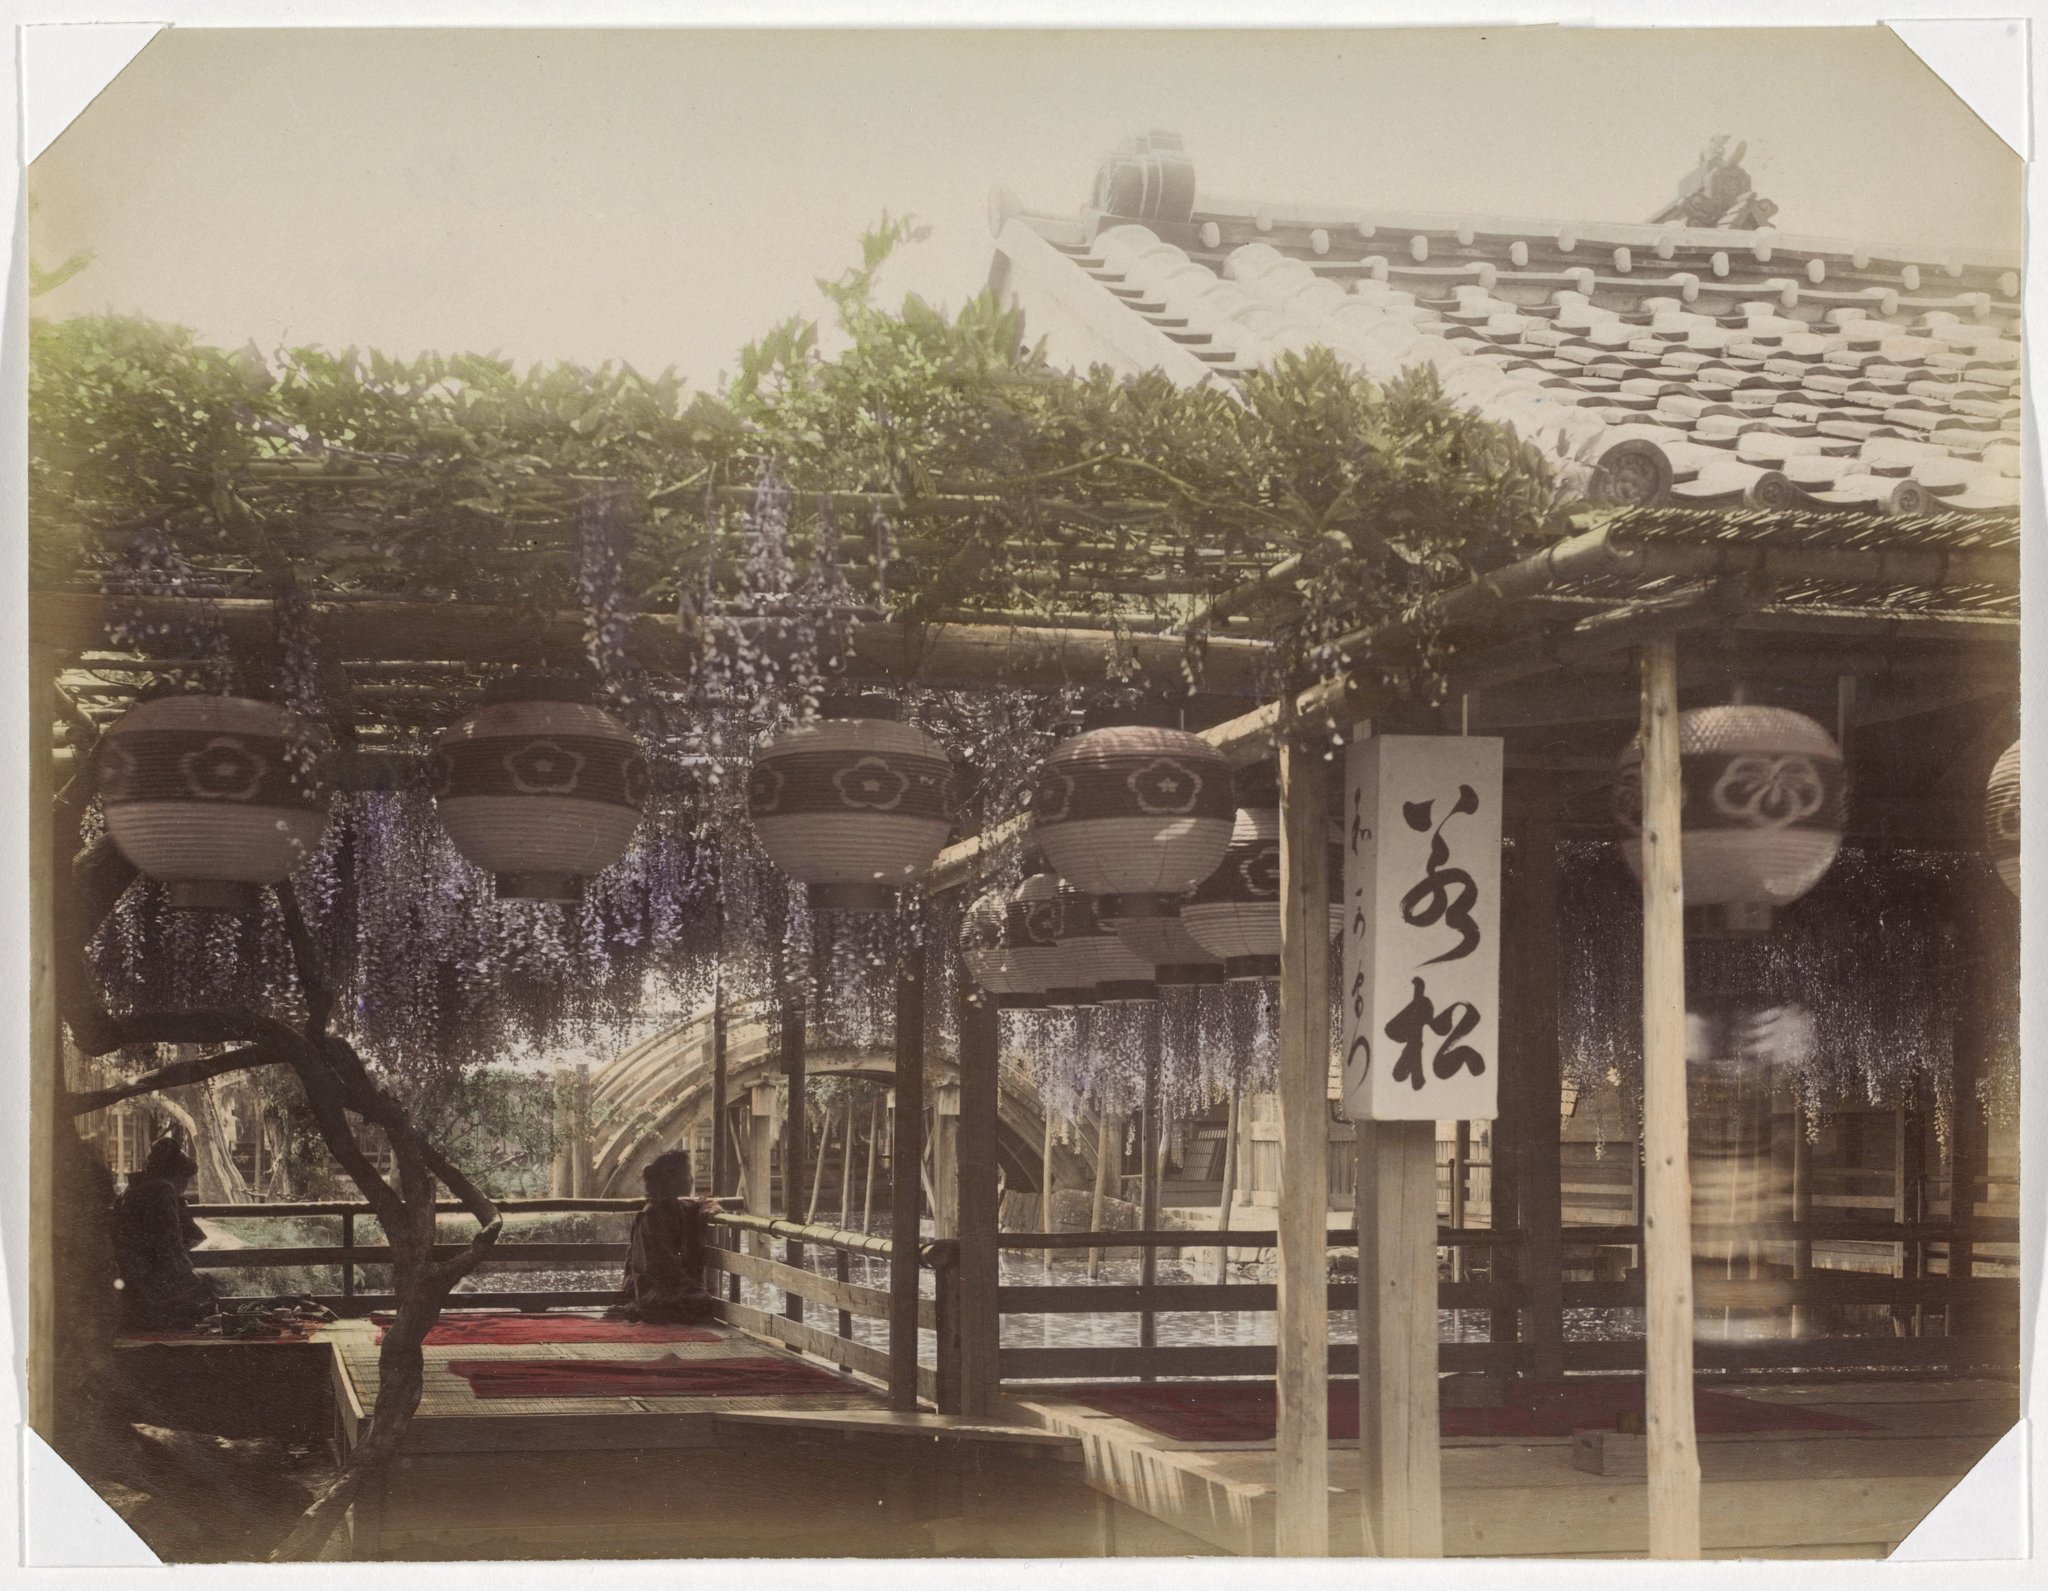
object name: photograph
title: Binnenplaats van theehuis Kameido met bloeiende wisteria in Tokyo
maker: Anonymous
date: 1890-1894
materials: cardboard, paper, photographic support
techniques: albumen print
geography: tokyo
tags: inn, coffee-house, public house, etc.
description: Onderdeel van Album met 69 foto's van een reis door Japan.